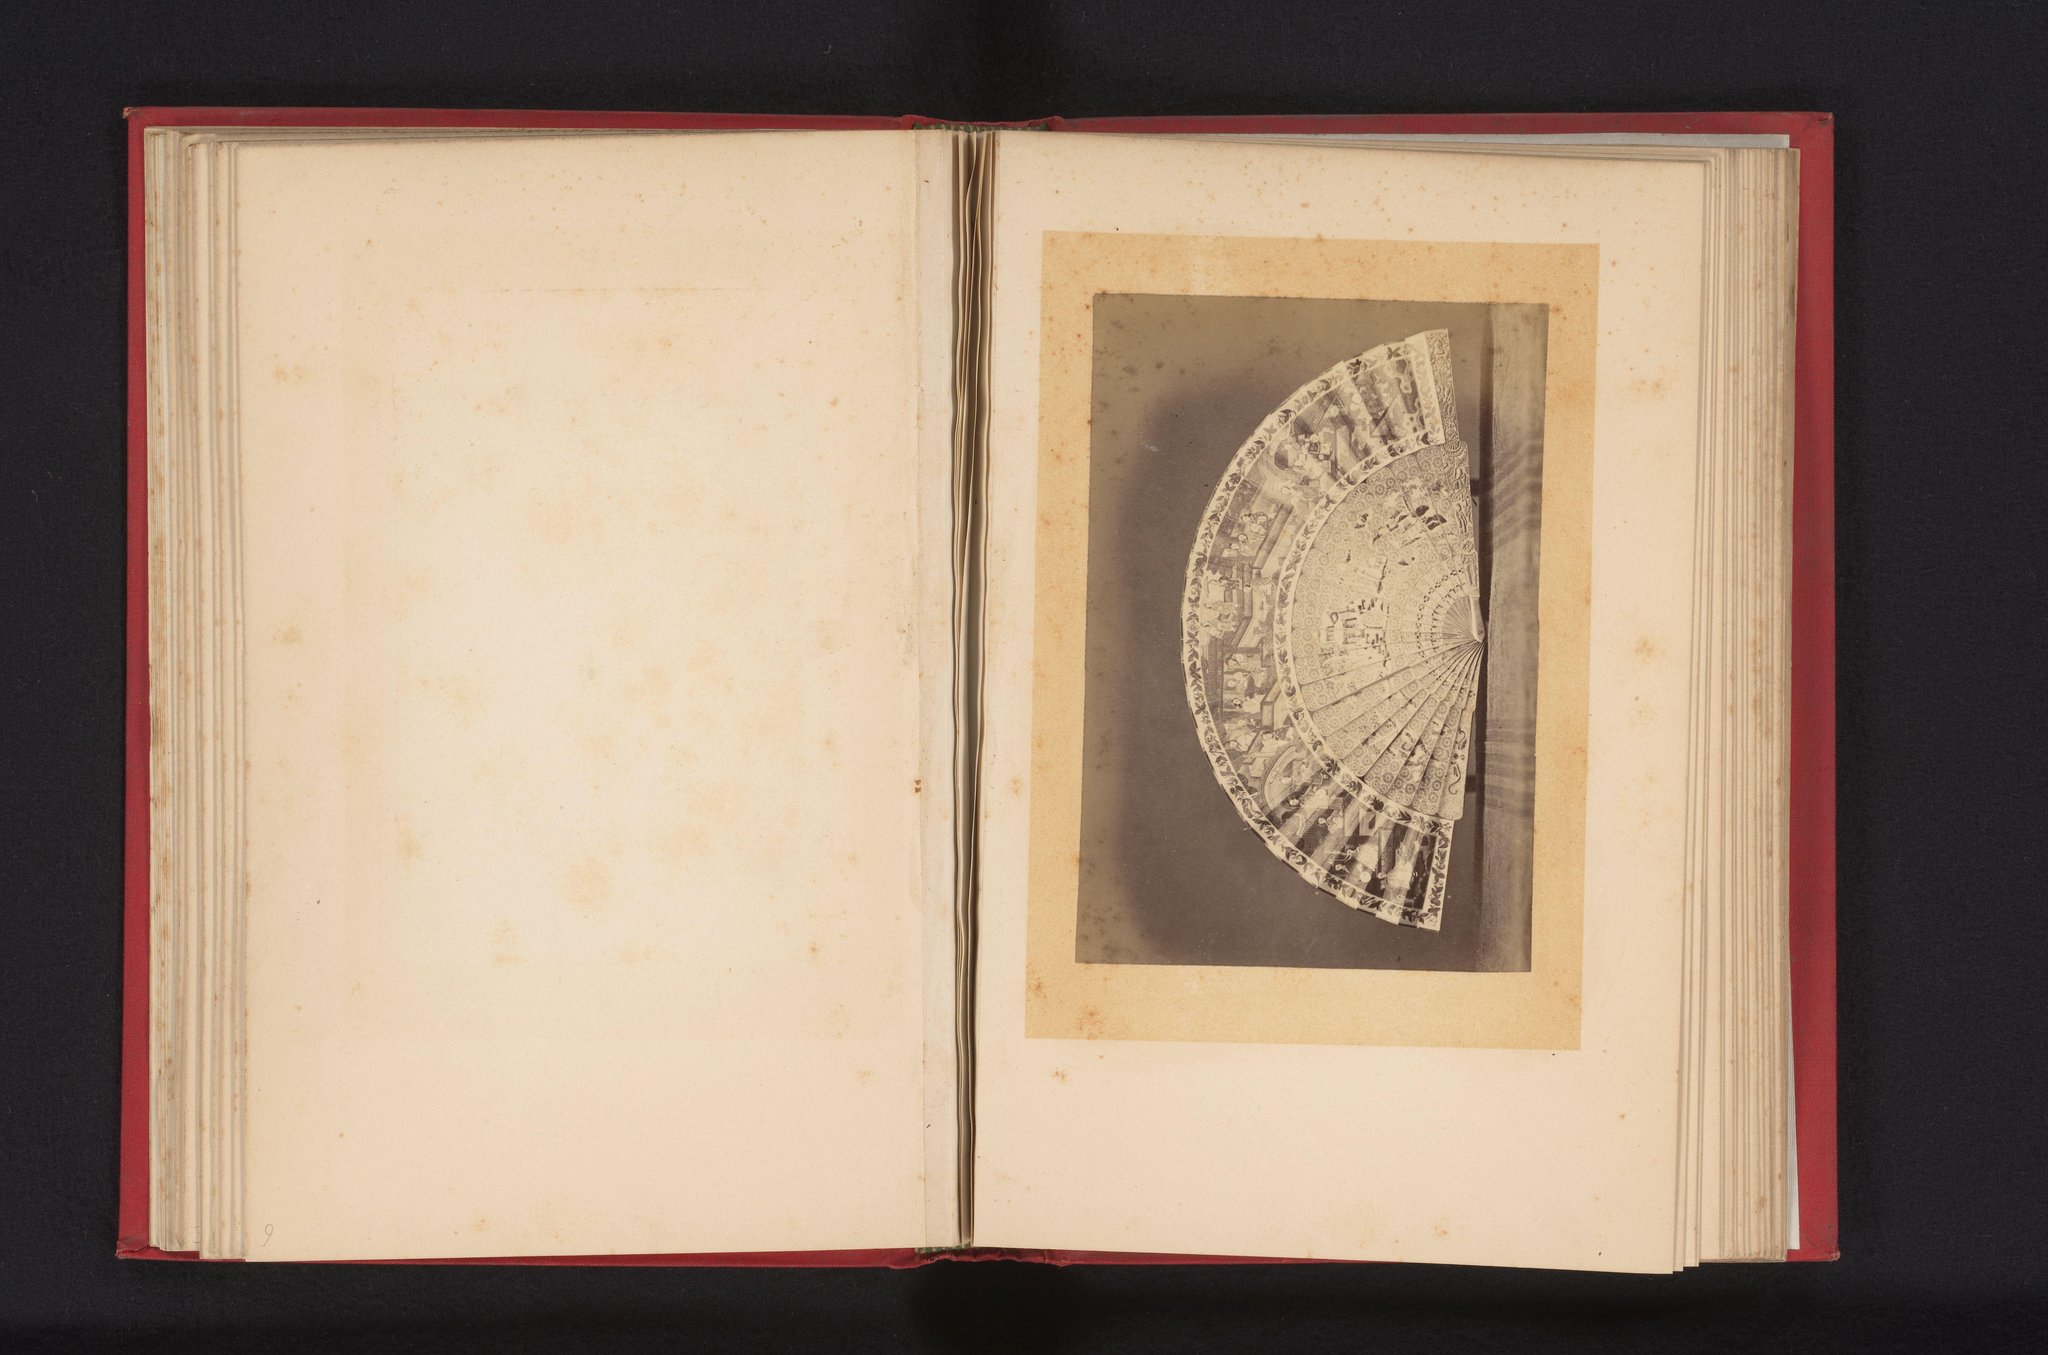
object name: photograph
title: Waaier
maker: Anonymous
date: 1872-1878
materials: photographic support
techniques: albumen print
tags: fan